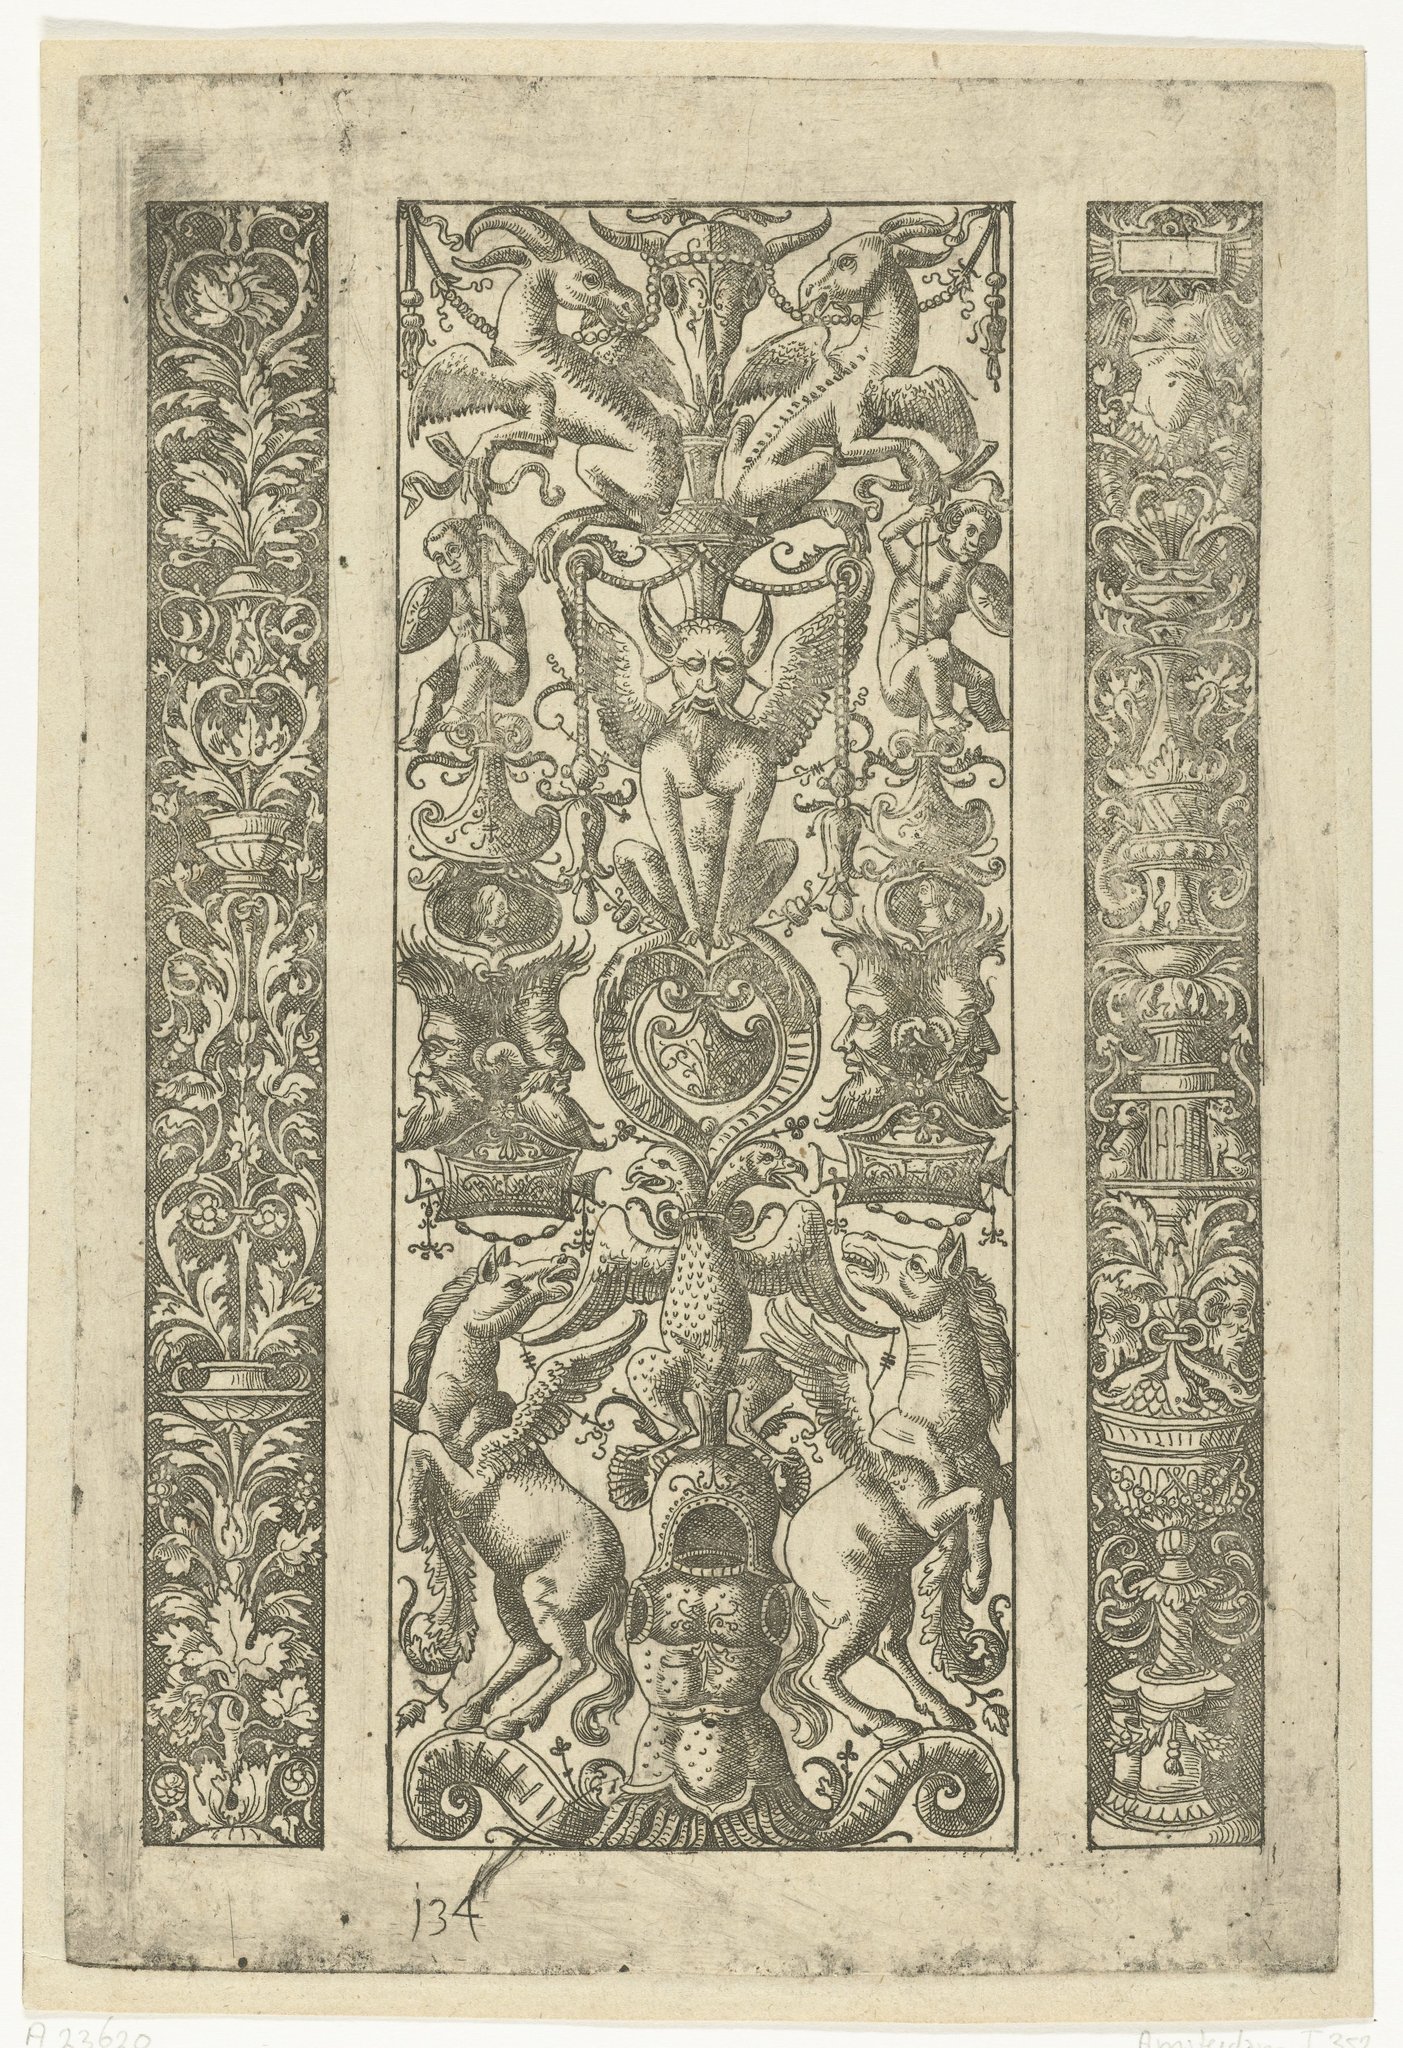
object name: print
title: Drie vlakdecoraties op een blad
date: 1520-1530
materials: paper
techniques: etching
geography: germany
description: Links en rechts een kandelaber met bladranken. In het midden een kandelaber met grotesken. Linksonder en rechtsonder staat een steigerend paard.